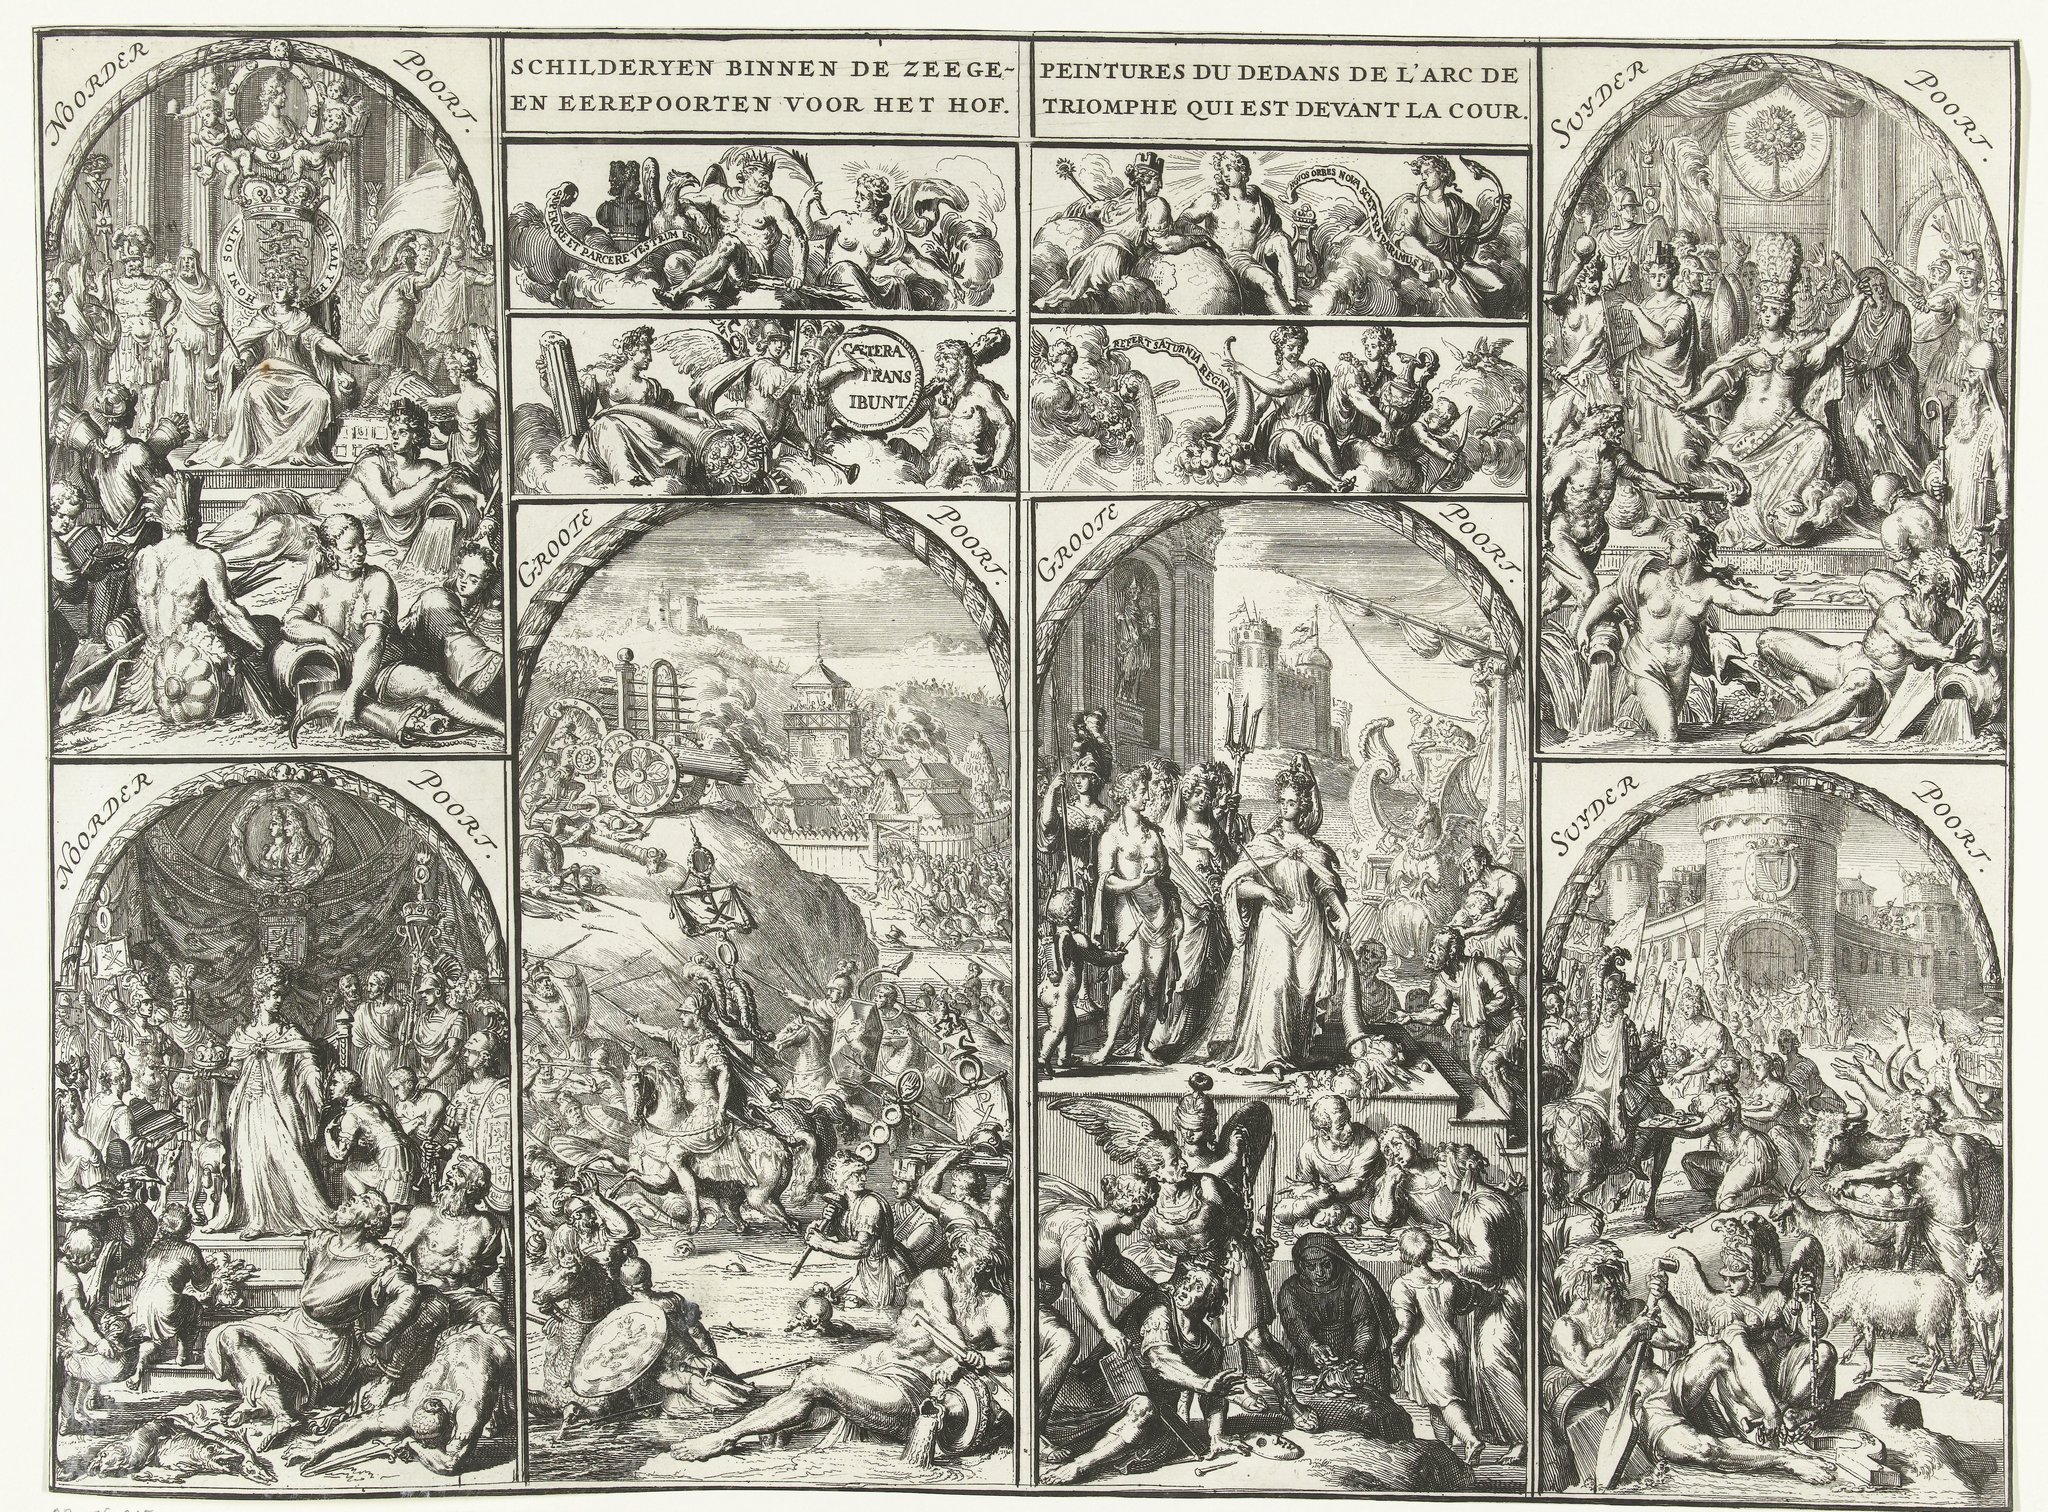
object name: print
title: Schilderyen binnen de zeege- en eerepoorten voor het Hof / Peintures du dedans de l'arc de triomphe qui est devant la cour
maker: romeyn de hooghe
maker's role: draughtsman, goldsmith, painter, print maker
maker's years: 1645-1708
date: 1691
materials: paper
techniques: etching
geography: northern netherlands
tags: william iii (prince of orange and king of england, scotland, and ireland), maria ii stuart (koningin van engeland, schotland en ierland), coat of arms (as symbol of the state, etc.) (+ nation; national), triumphal entry and public reception, pageant, 'entrée solennelle', 'joyeuse entrée'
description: Overzicht van zes grote en vier kleine schilderijen op de triomfbogen opgesteld voor het Buitenhof, 5 februari 1691. Voornamelijk allegorische voorstellingen van de overwinningen van stadhouder-koning Willem III en de deugdzaamheid van koningin Maria Stuart.